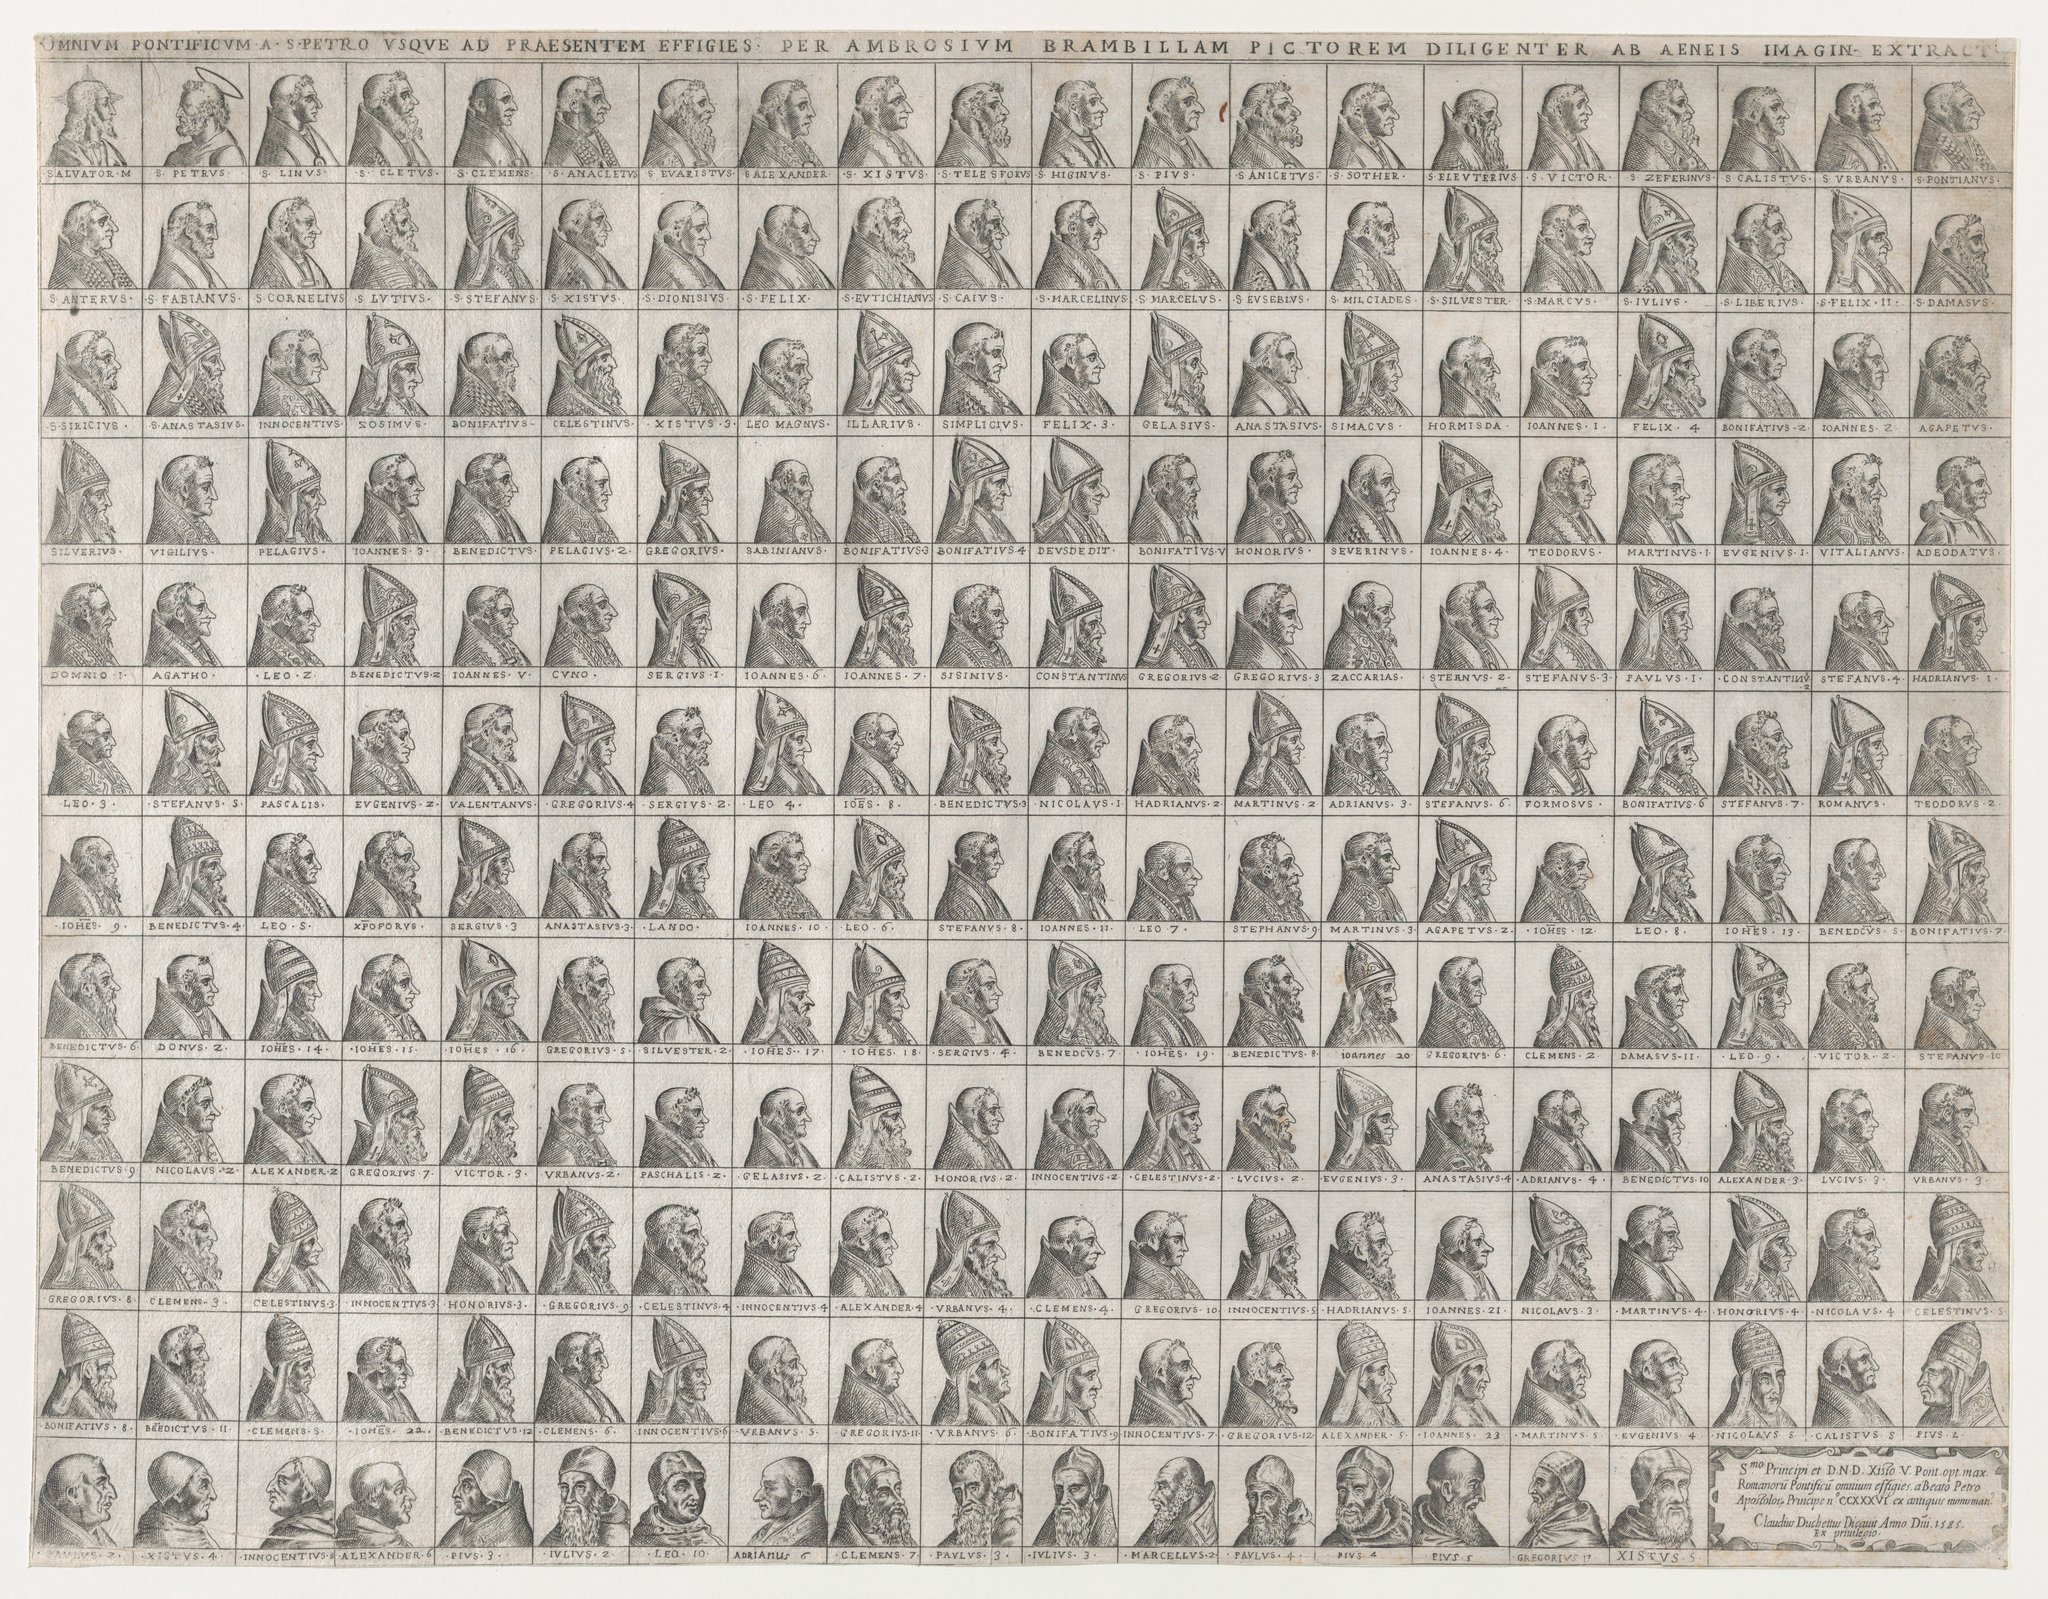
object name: print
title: Small Portraits of the Popes from Christ to Sixtus V, from "Speculum Romanae Magnificentiae"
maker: giovanni ambrogio brambilla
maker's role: artist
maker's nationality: italian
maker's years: 1575-1599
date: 1585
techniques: engraving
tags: profiles,christ,popes